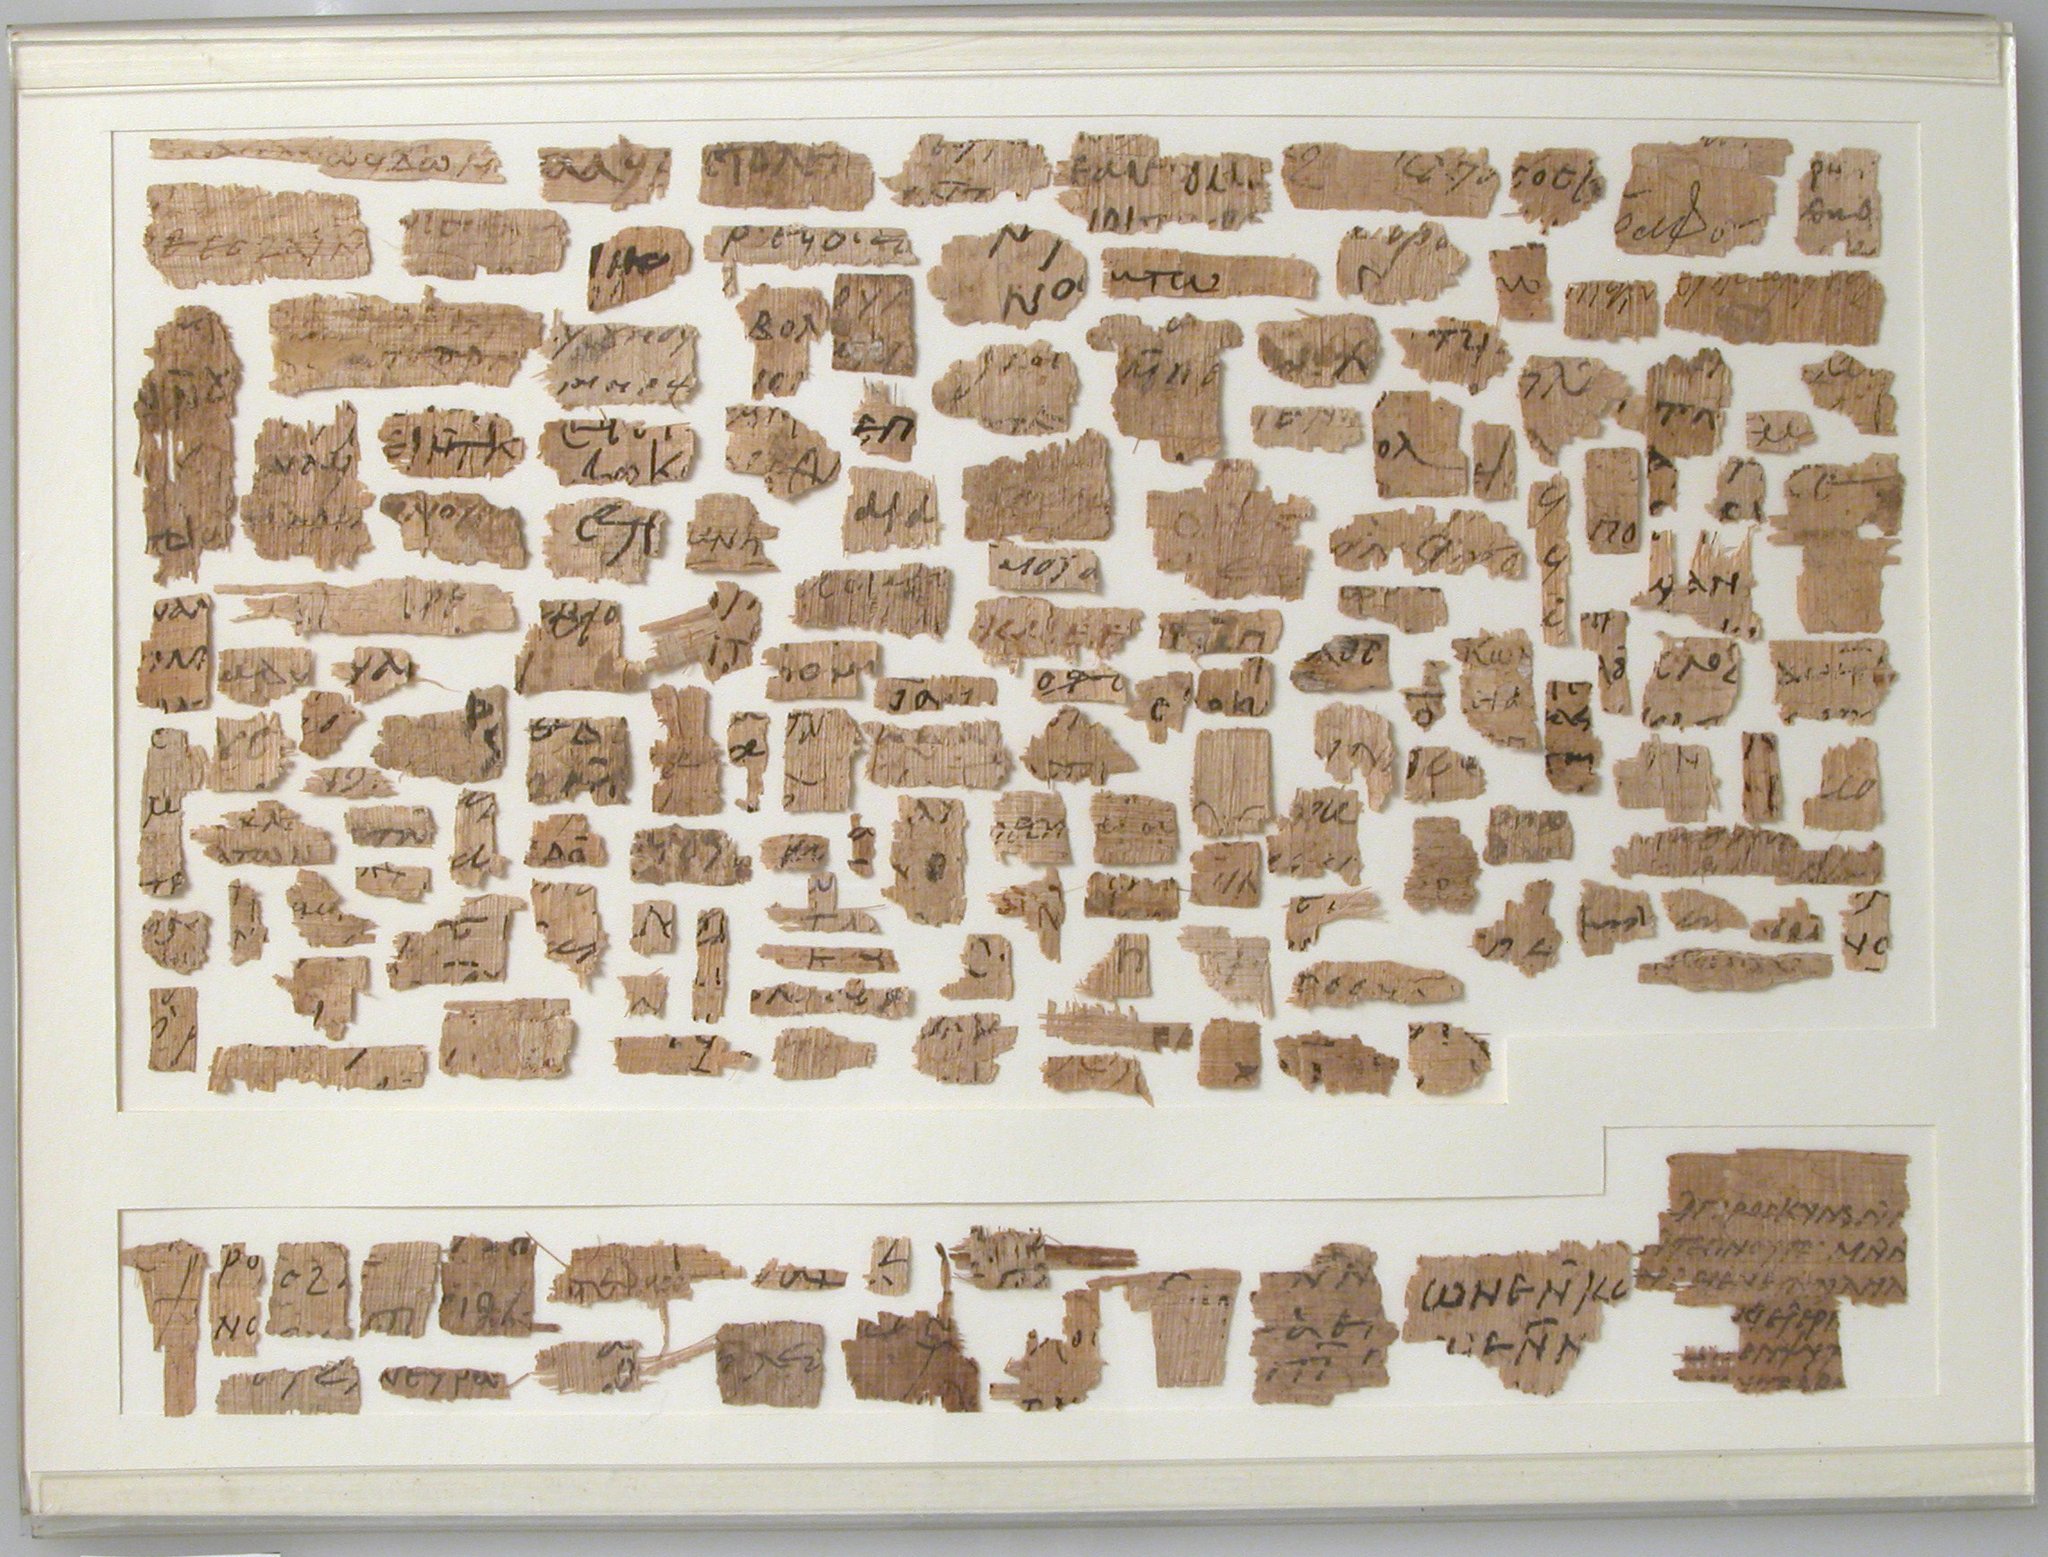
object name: fragment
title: Papyri Fragments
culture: coptic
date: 601-700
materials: ink, papyrus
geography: egypt